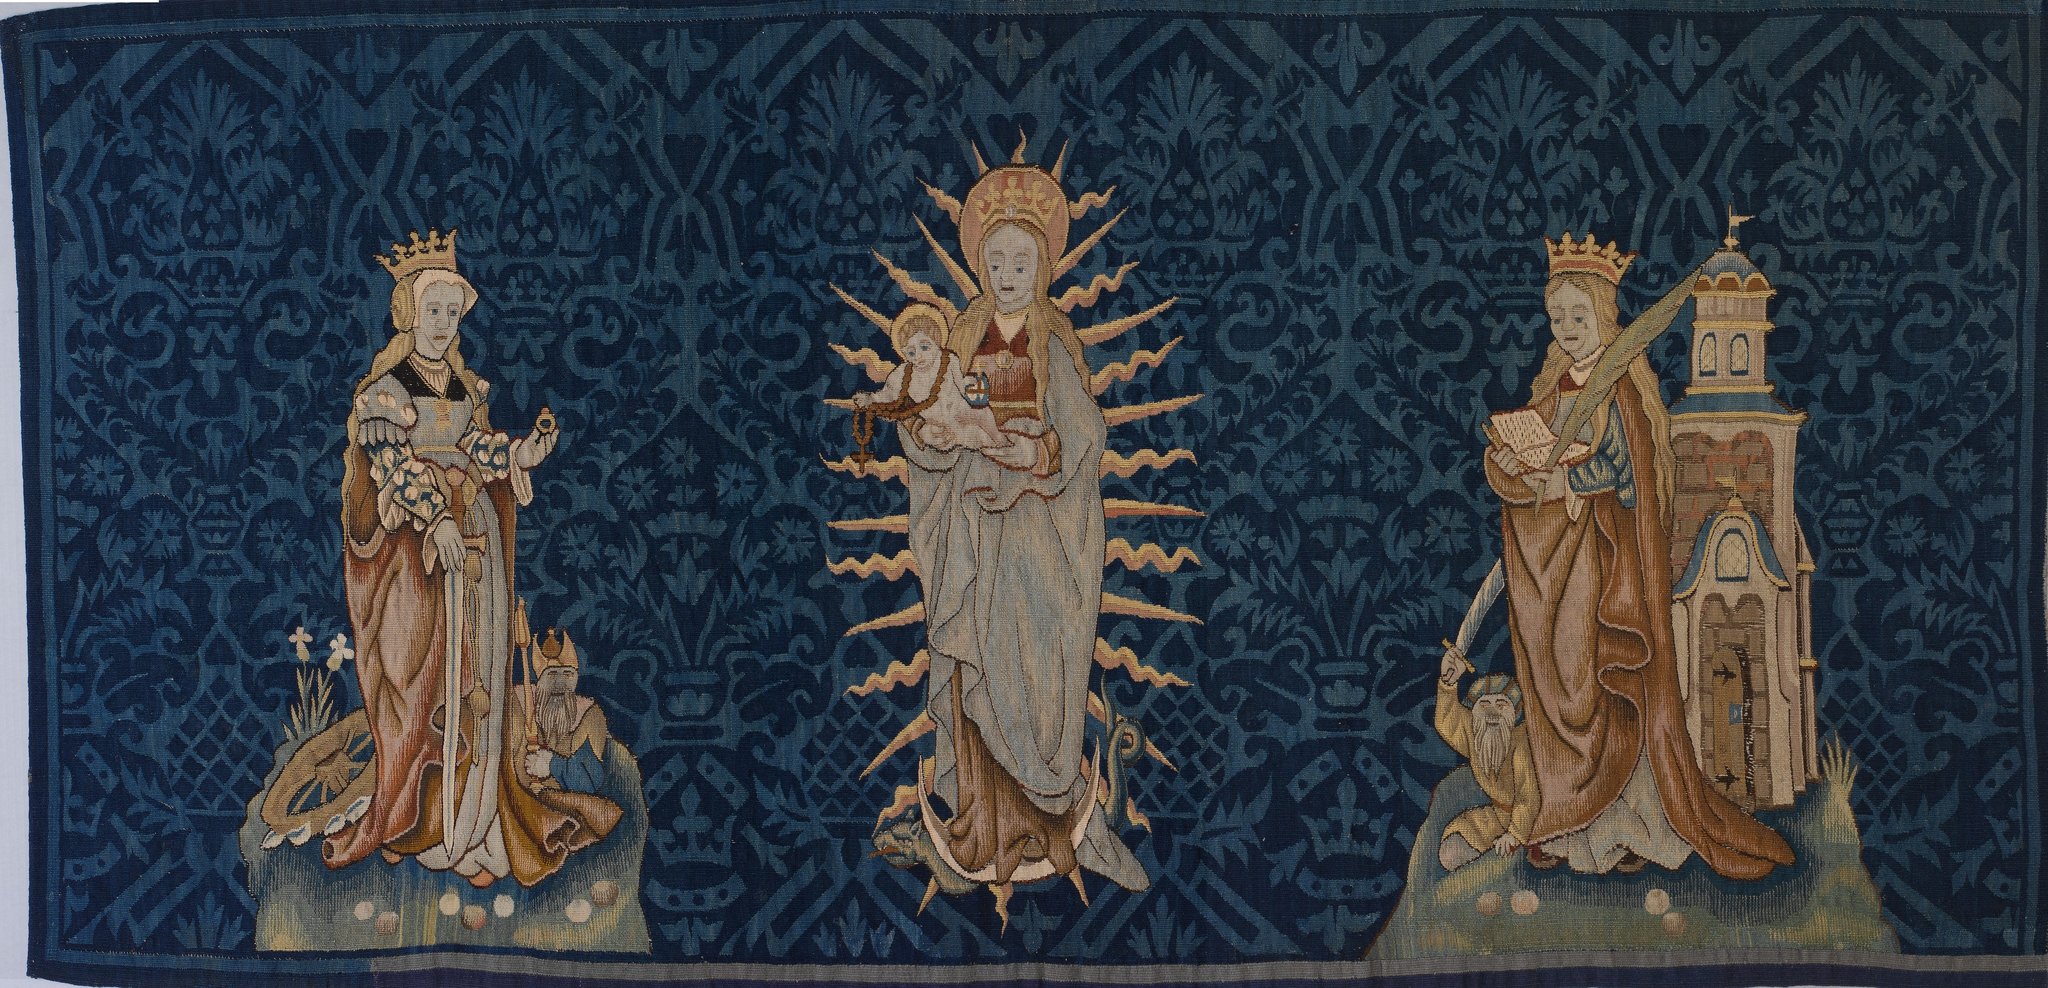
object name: antependium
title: The Virgin of The Apocalypse with Saint Catherine and Saint Barbara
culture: south netherlandish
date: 1525-1550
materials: wool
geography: south netherlands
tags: women,madonna and child,saints